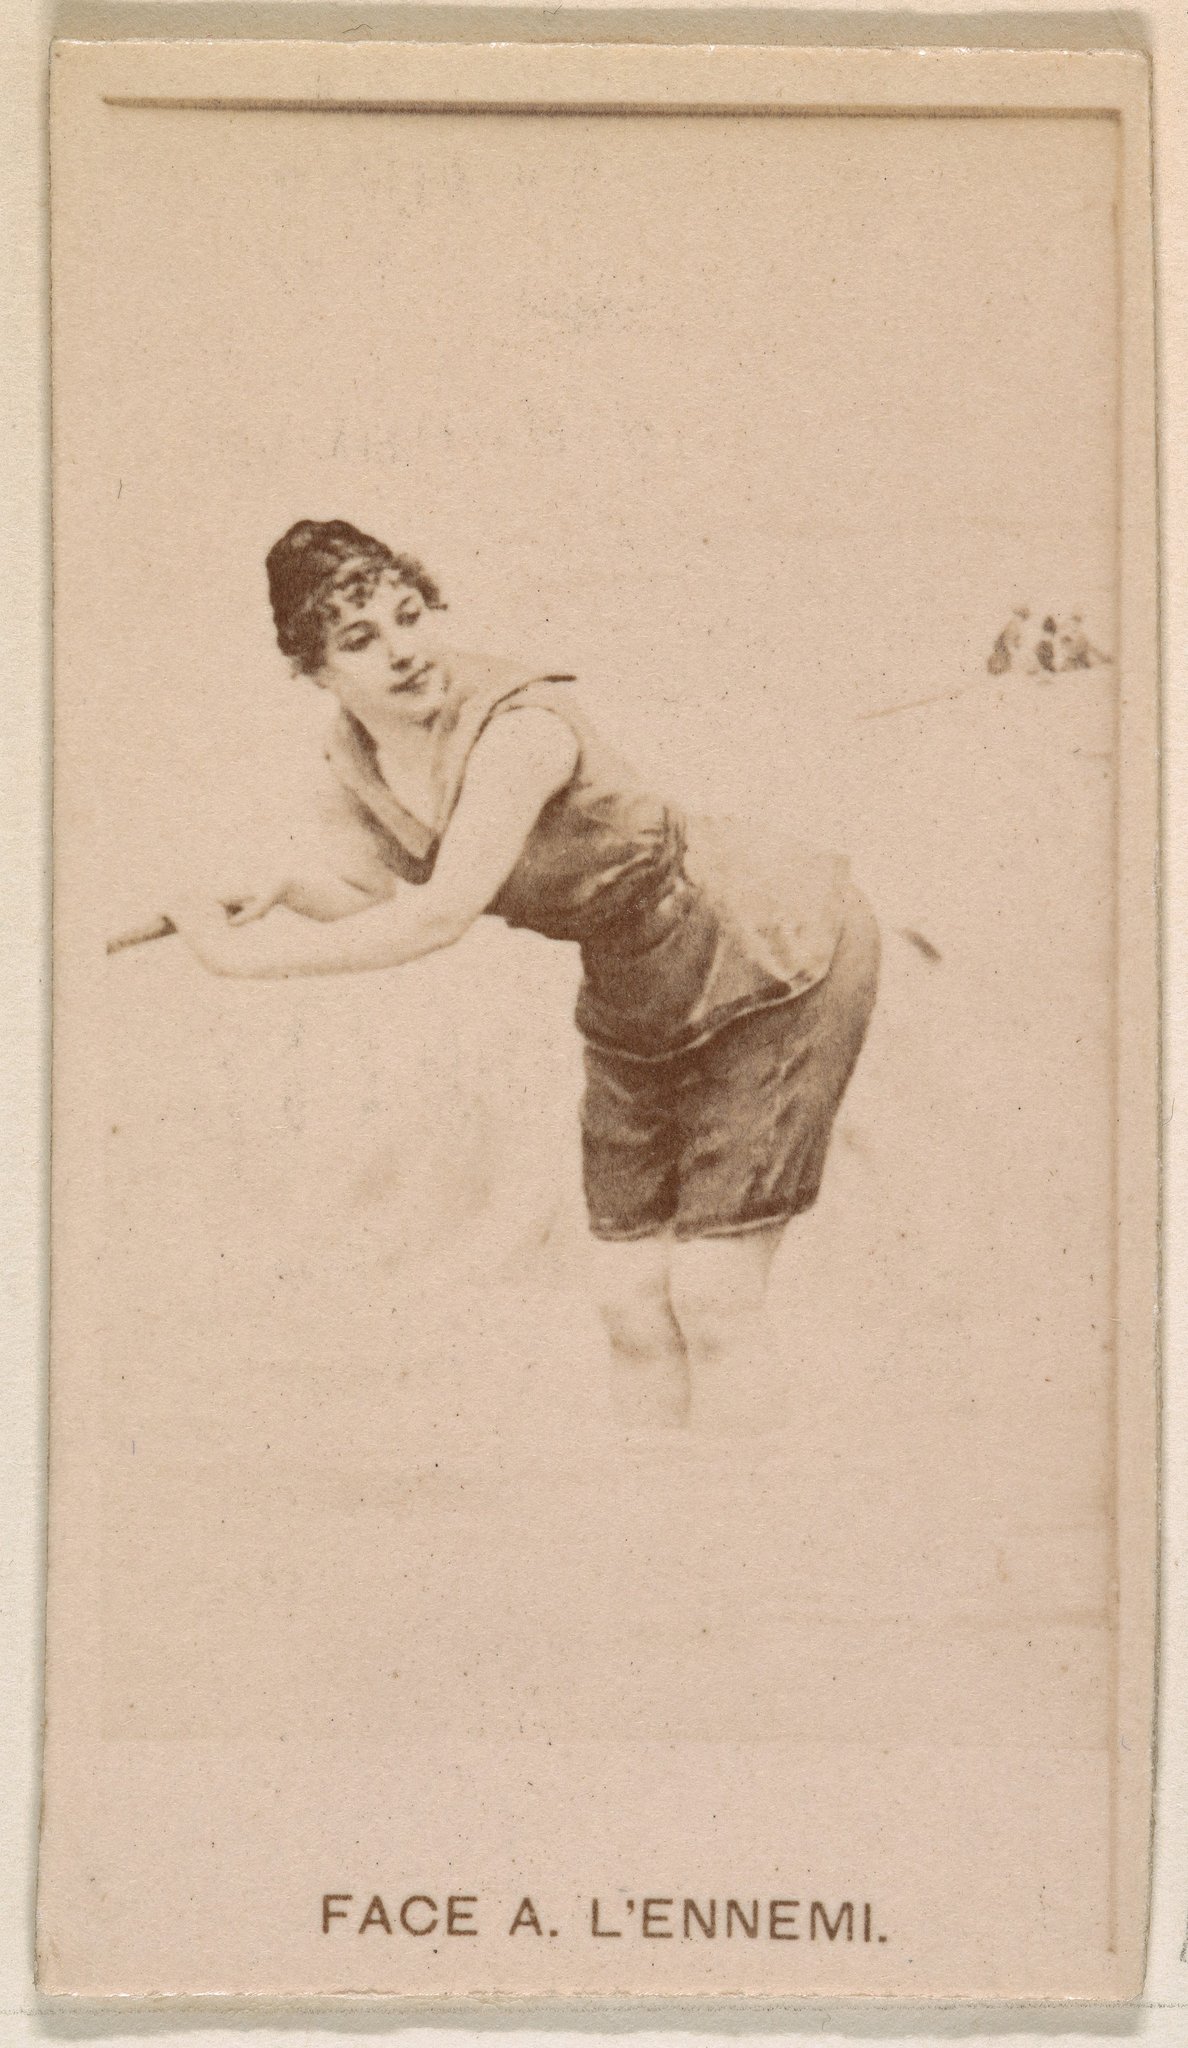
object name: photograph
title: Face A. L'ennemi, from the Actresses series (N245) issued by Kinney Brothers to promote Sweet Caporal Cigarettes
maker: kinney brothers tobacco company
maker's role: publisher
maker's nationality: american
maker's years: 1869-2011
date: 1890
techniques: albumen silver print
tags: portraits,women,actresses